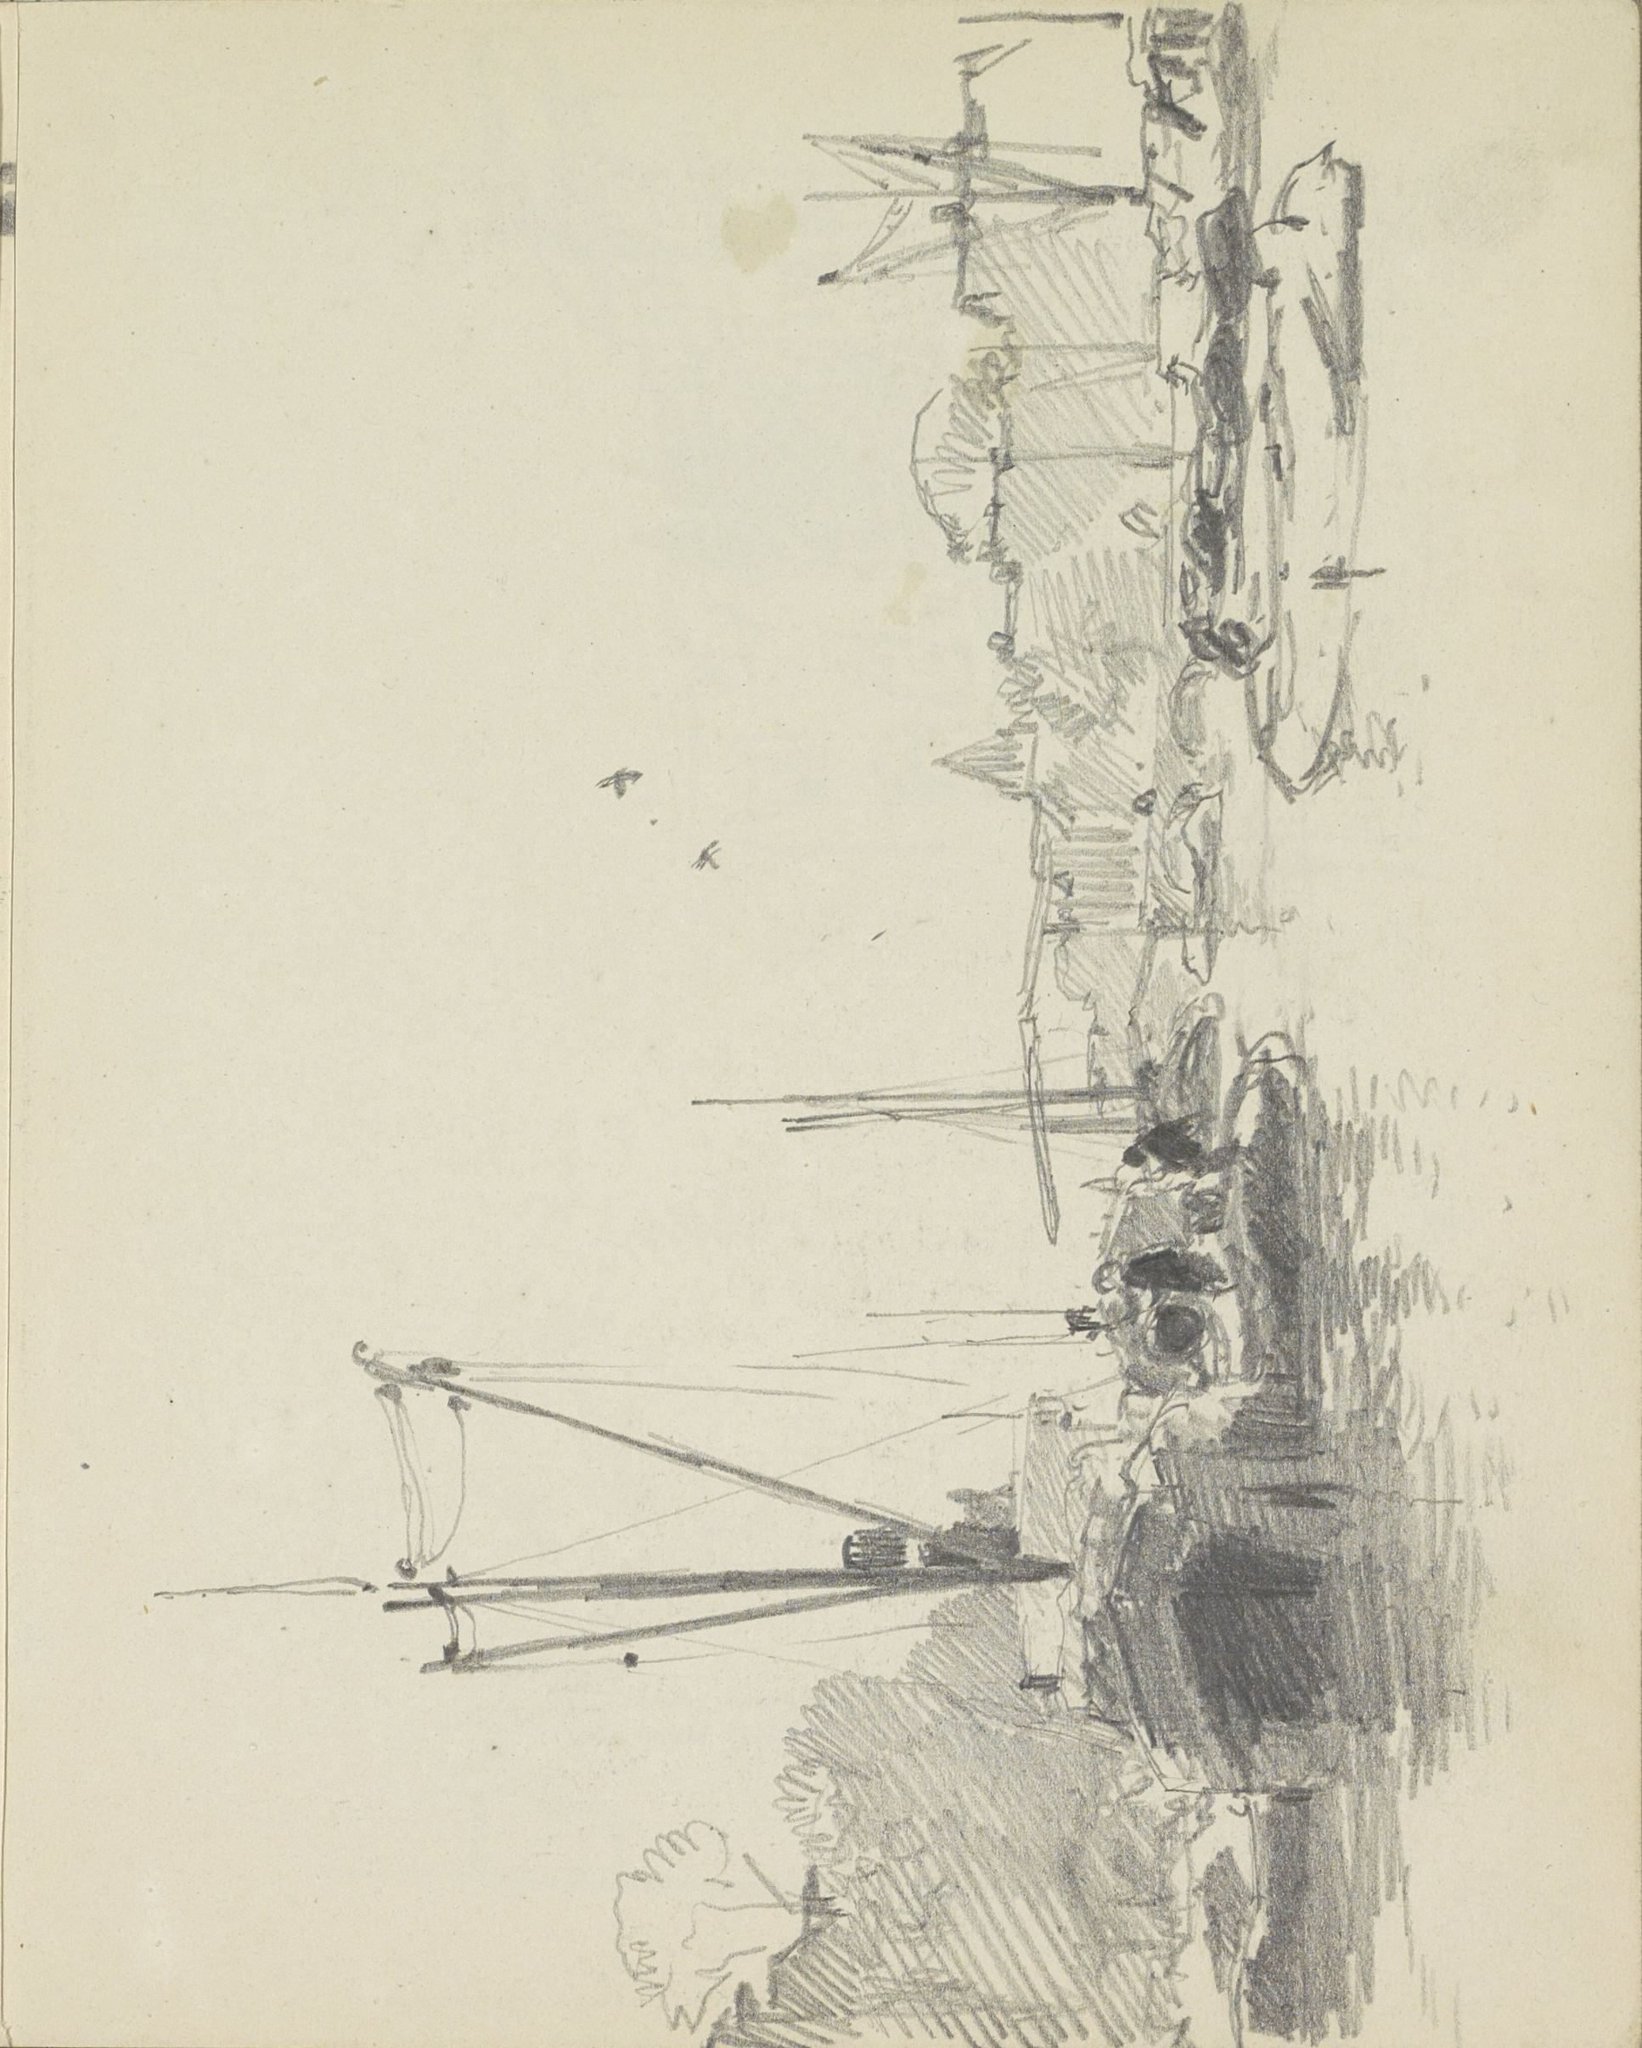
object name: sketchbook leaf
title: Gezicht op de Amstel te Amsterdam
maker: cornelis vreedenburgh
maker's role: draughtsman, print maker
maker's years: 1880-1946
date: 1890-1946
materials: paper, pencil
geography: amsterdam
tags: canals, waters (in city), amsterdam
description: Blad 10 recto uit een schetsboek met 76 bladen.